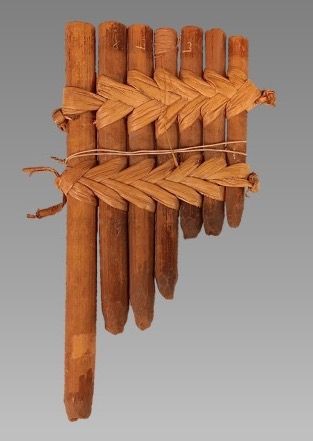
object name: bue balabala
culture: melanesian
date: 1867-1900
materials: bamboo, fiber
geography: vanuatu